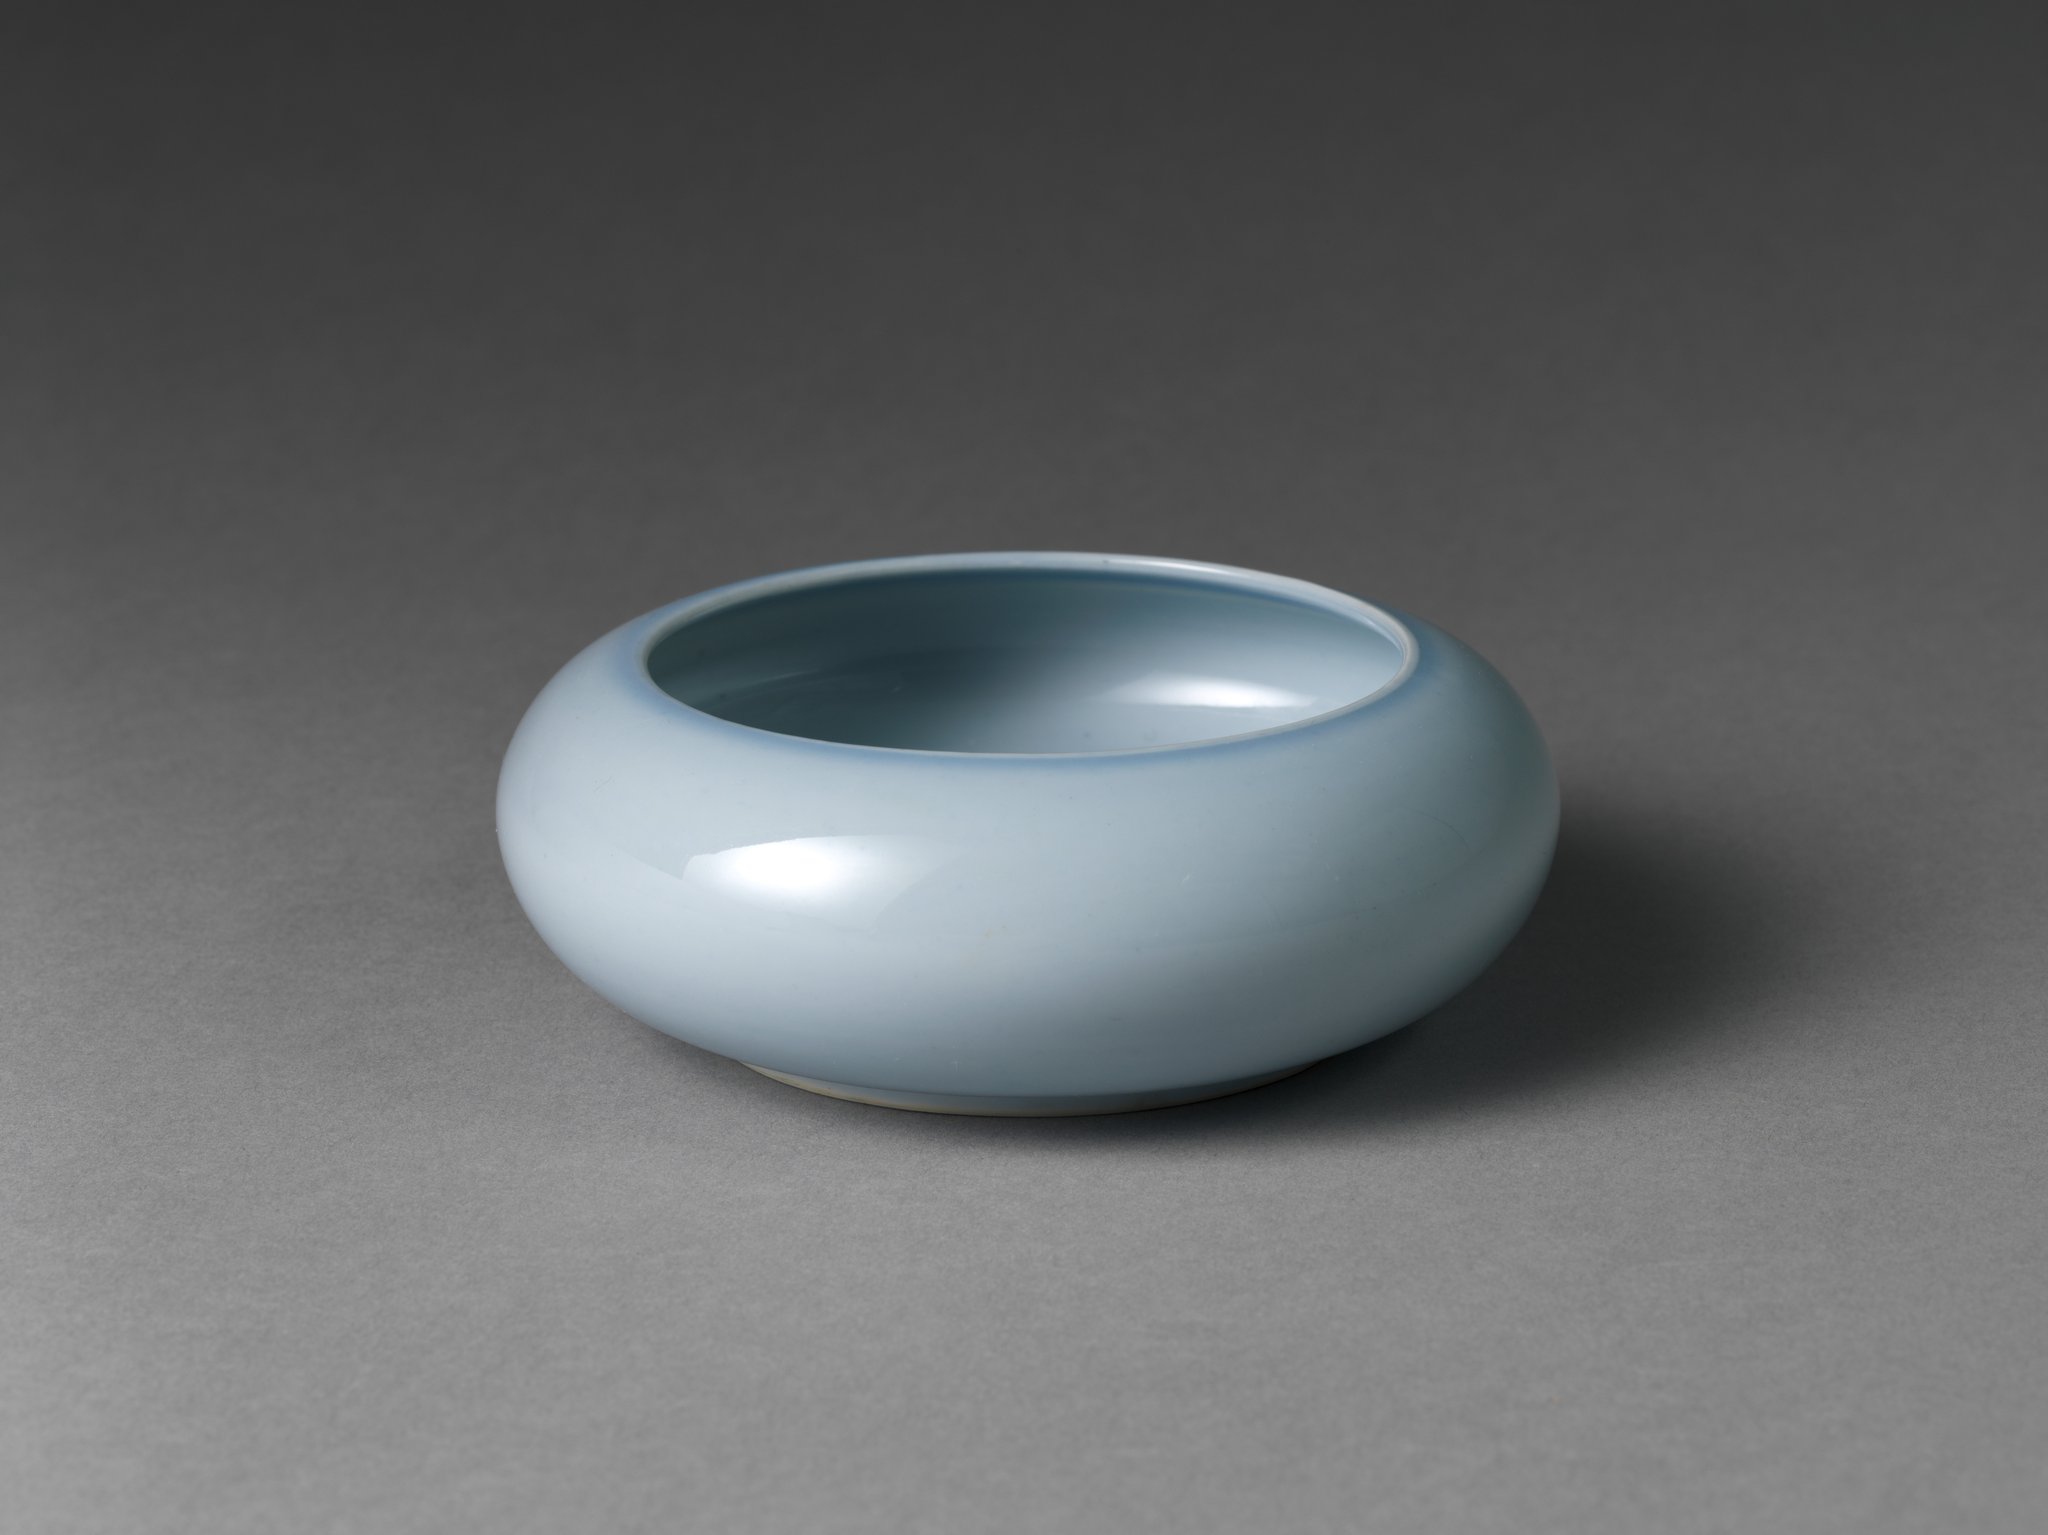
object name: brush washer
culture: chinese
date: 1700-1722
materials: glaze, porcelain